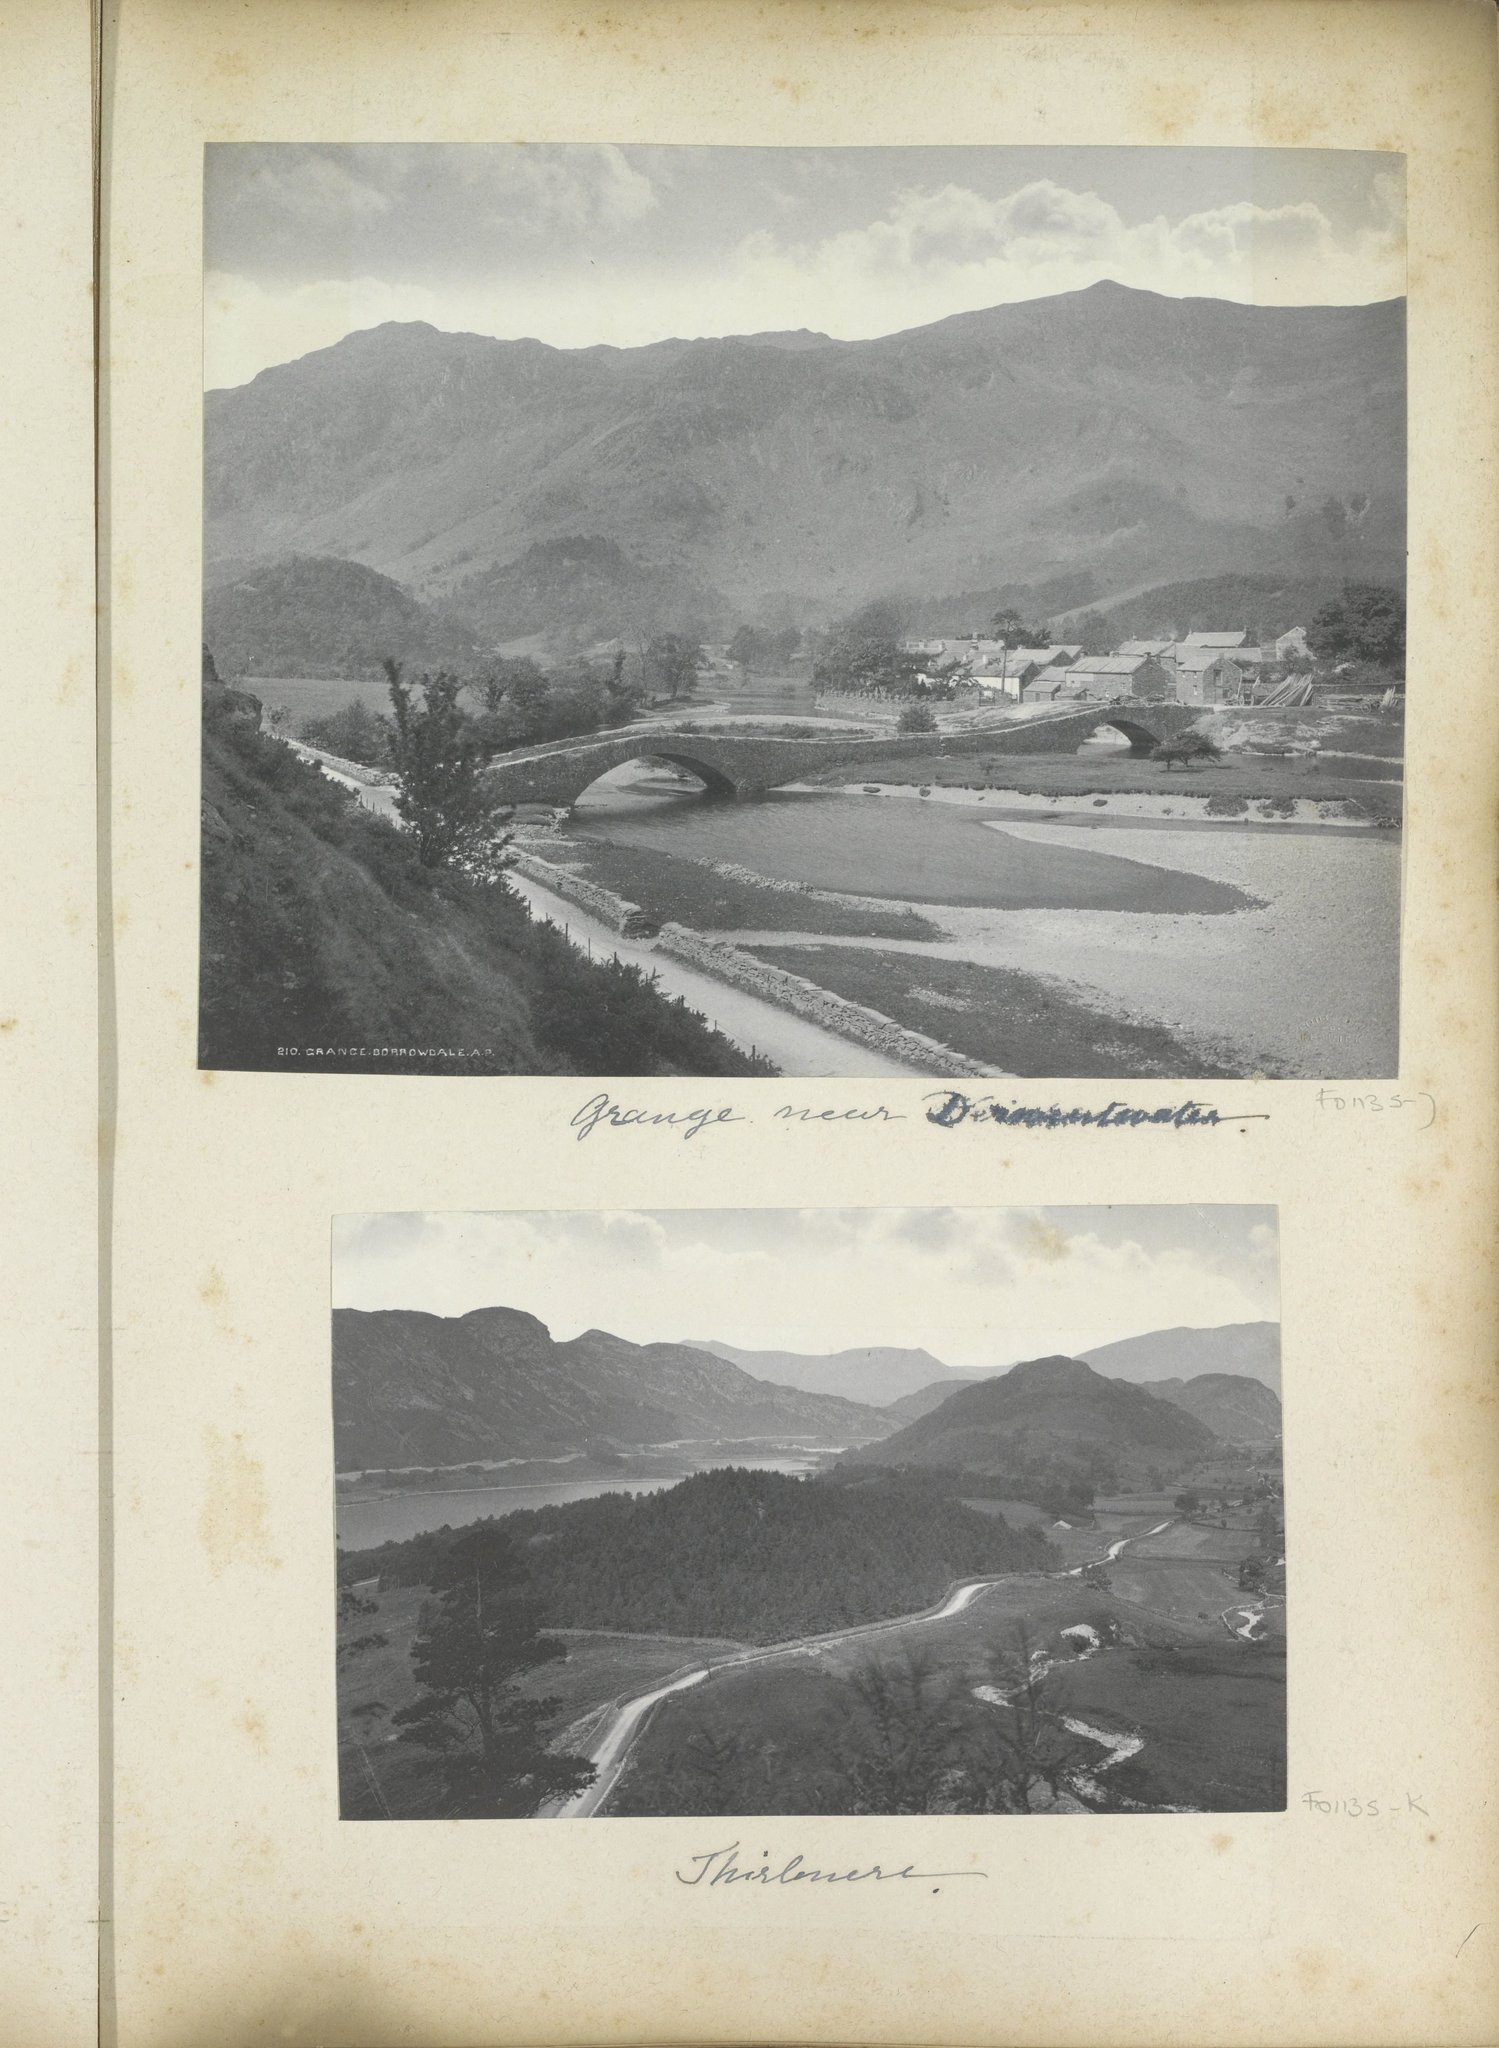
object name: photograph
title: Landschap met bergen en weg bij Thirlmere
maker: Anonymous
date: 1898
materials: paper, photographic support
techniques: platinum process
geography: thirlmere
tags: prospect of village, silhouette of village, landscape with bridge, viaduct or aqueduct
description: Onderdeel van Reisalbum met foto's van bezienswaardigheden in Engeland en Frankrijk.